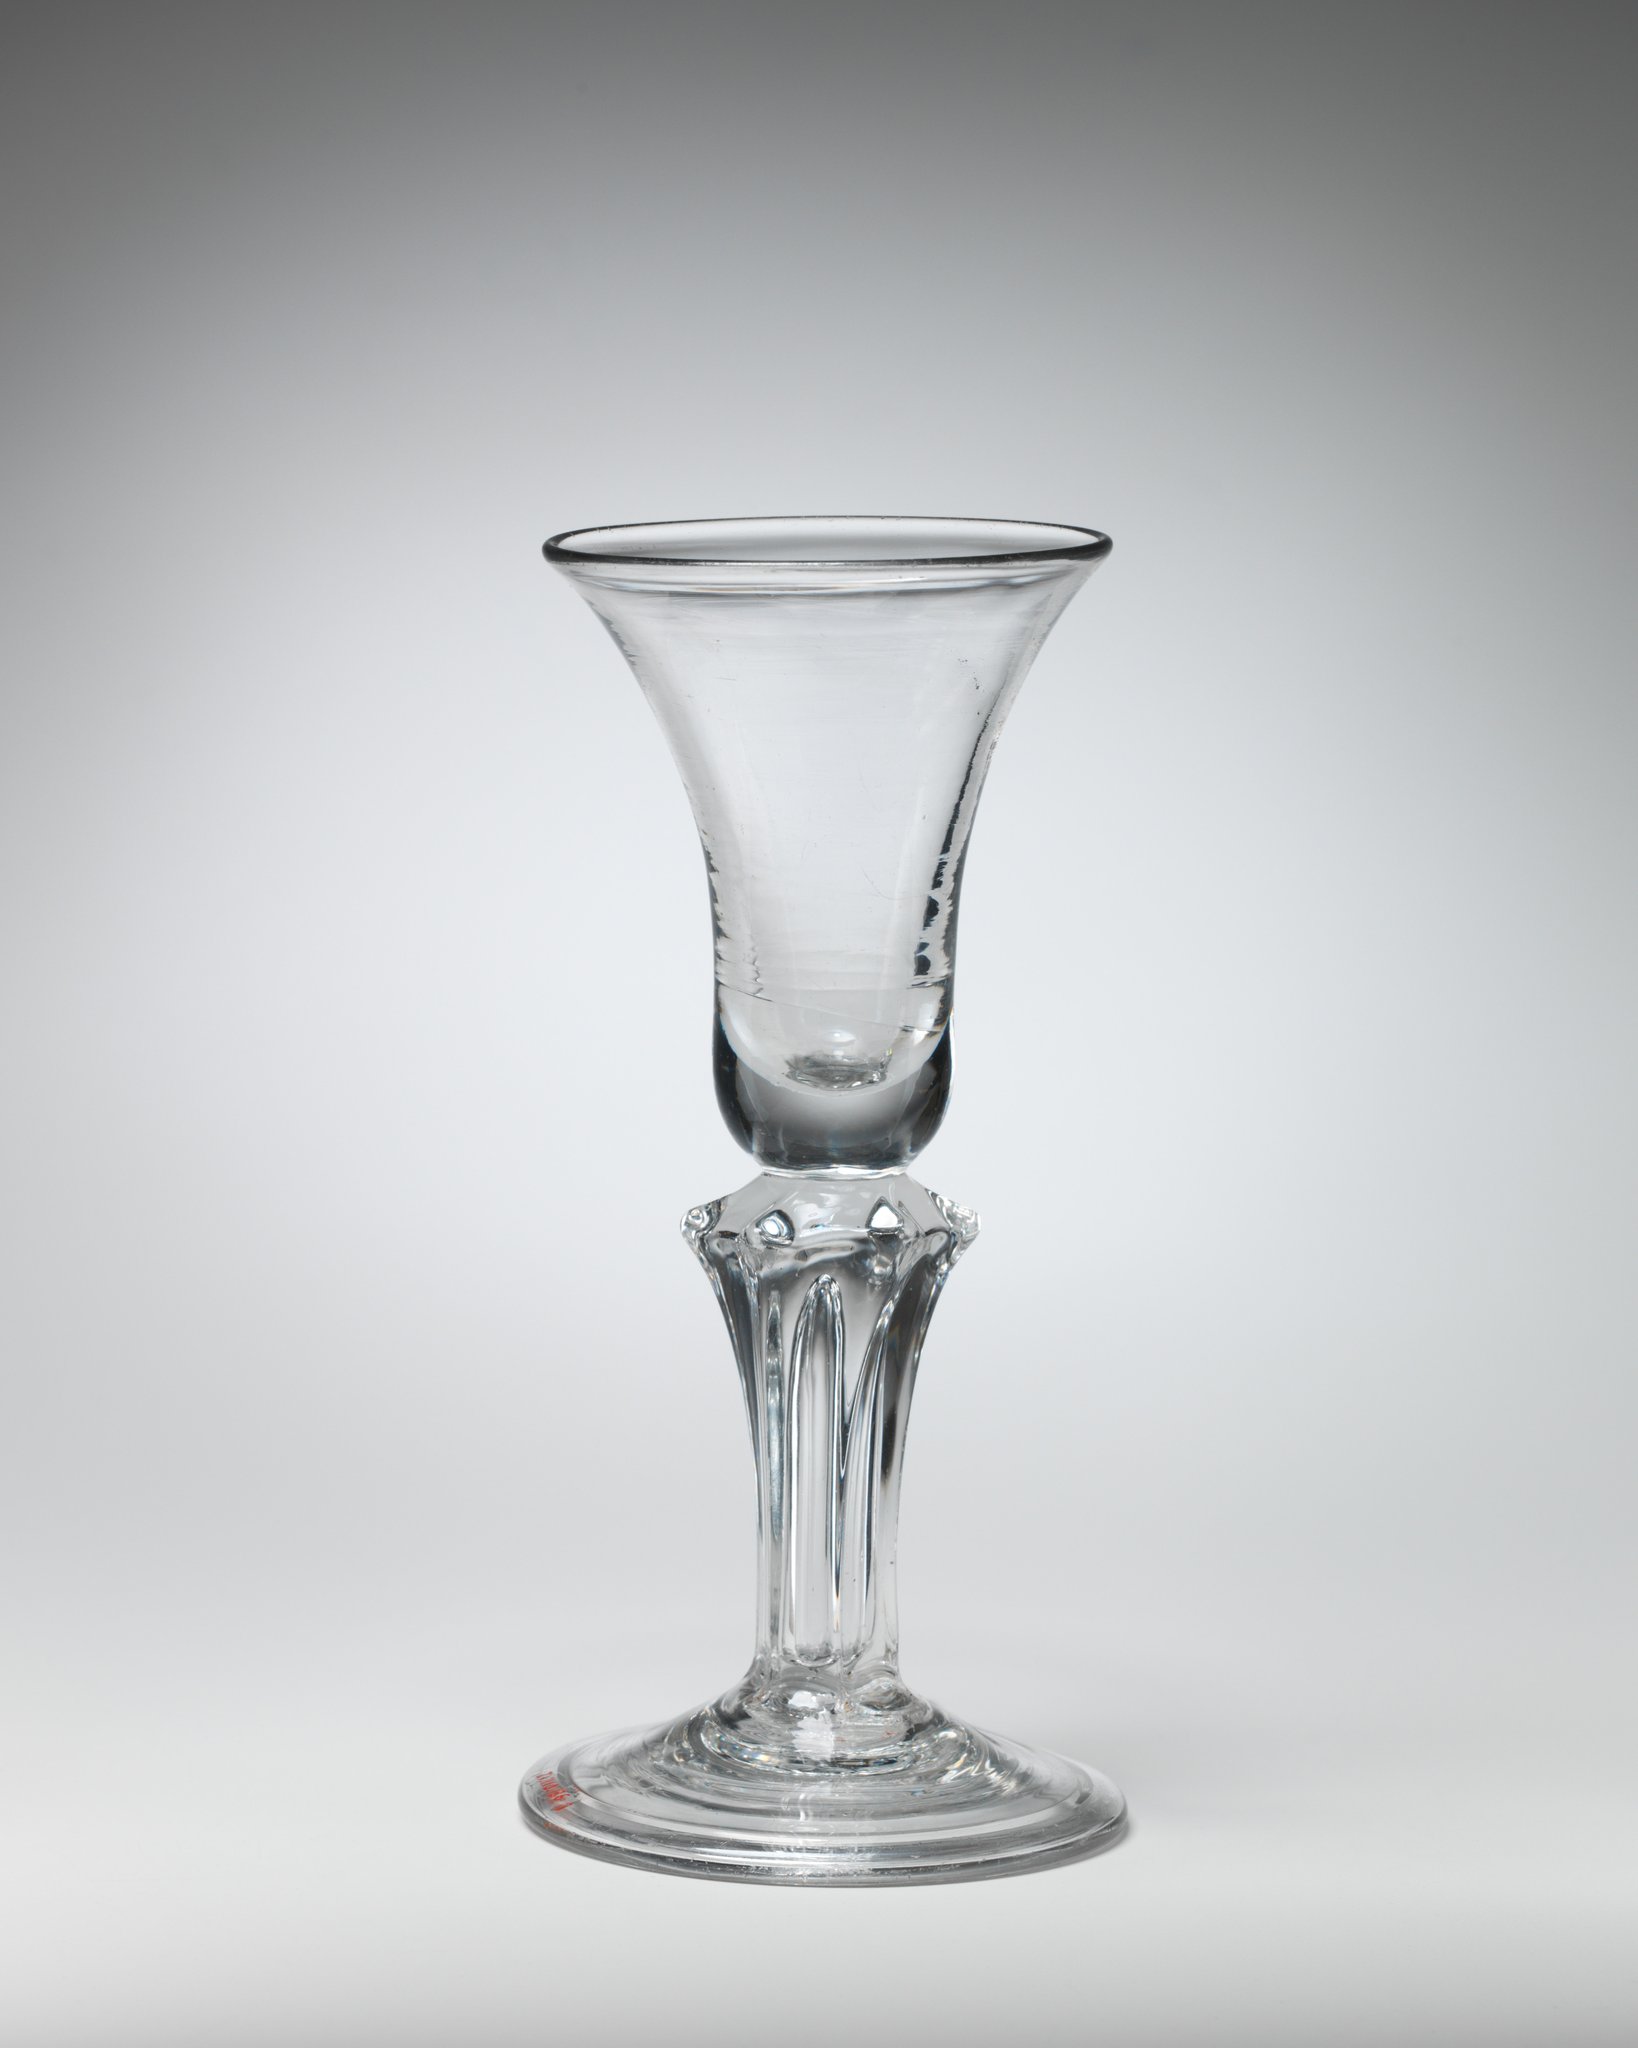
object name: wineglass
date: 1720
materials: glass